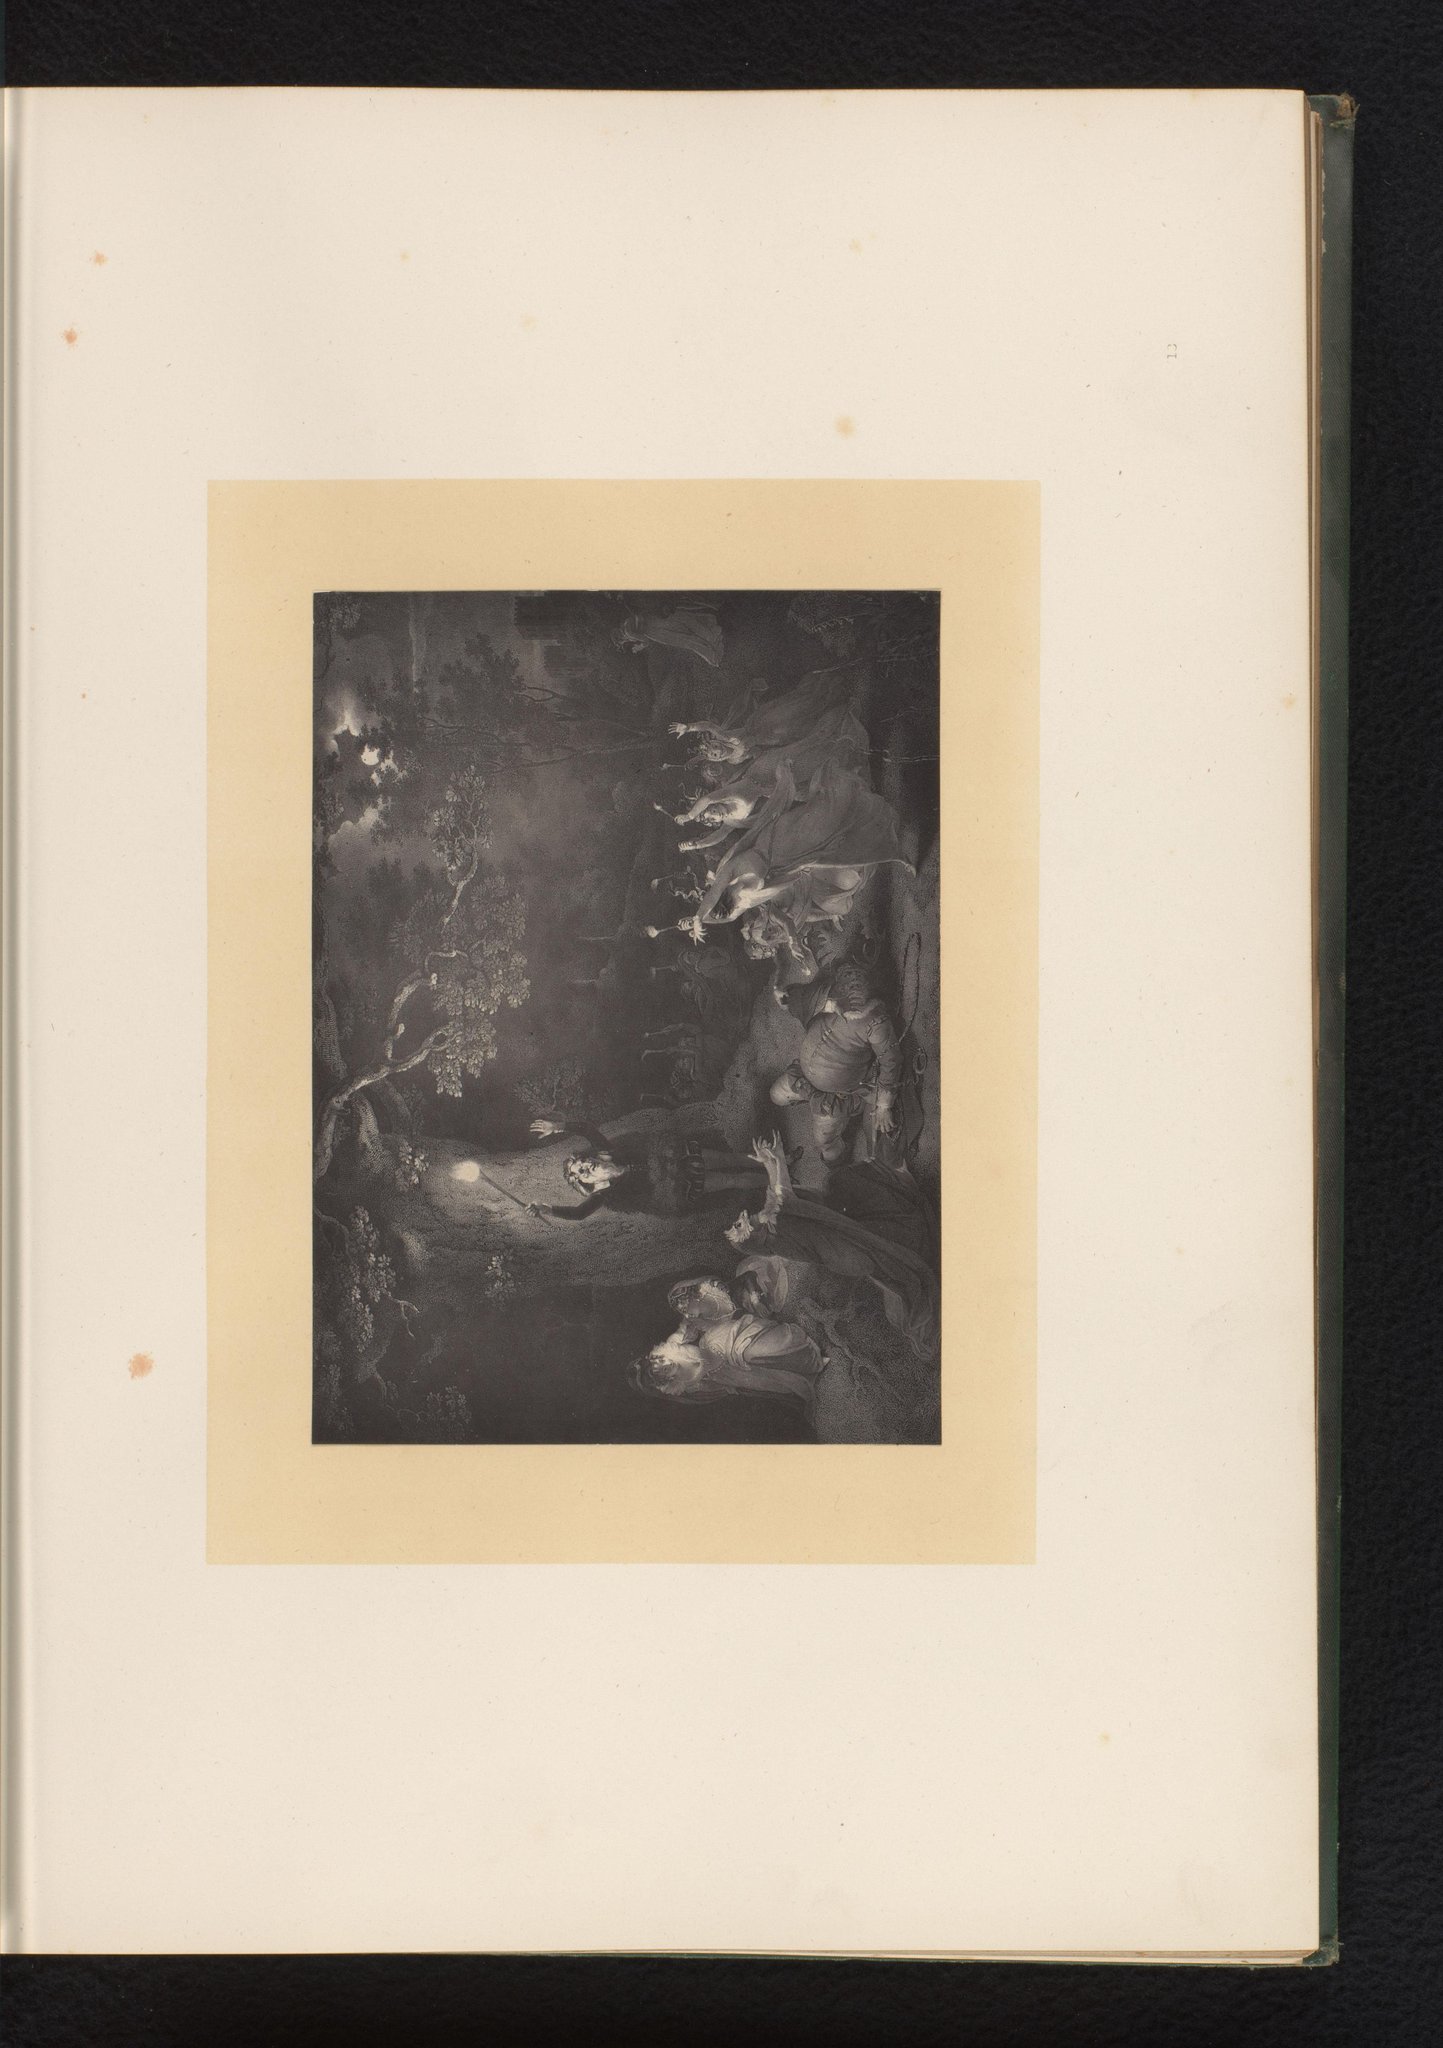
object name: page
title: The Merry Wives of Windsor, Act V, Scene 5: Windsor Park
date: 1874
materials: paper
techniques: woodburytype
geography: london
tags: comedy